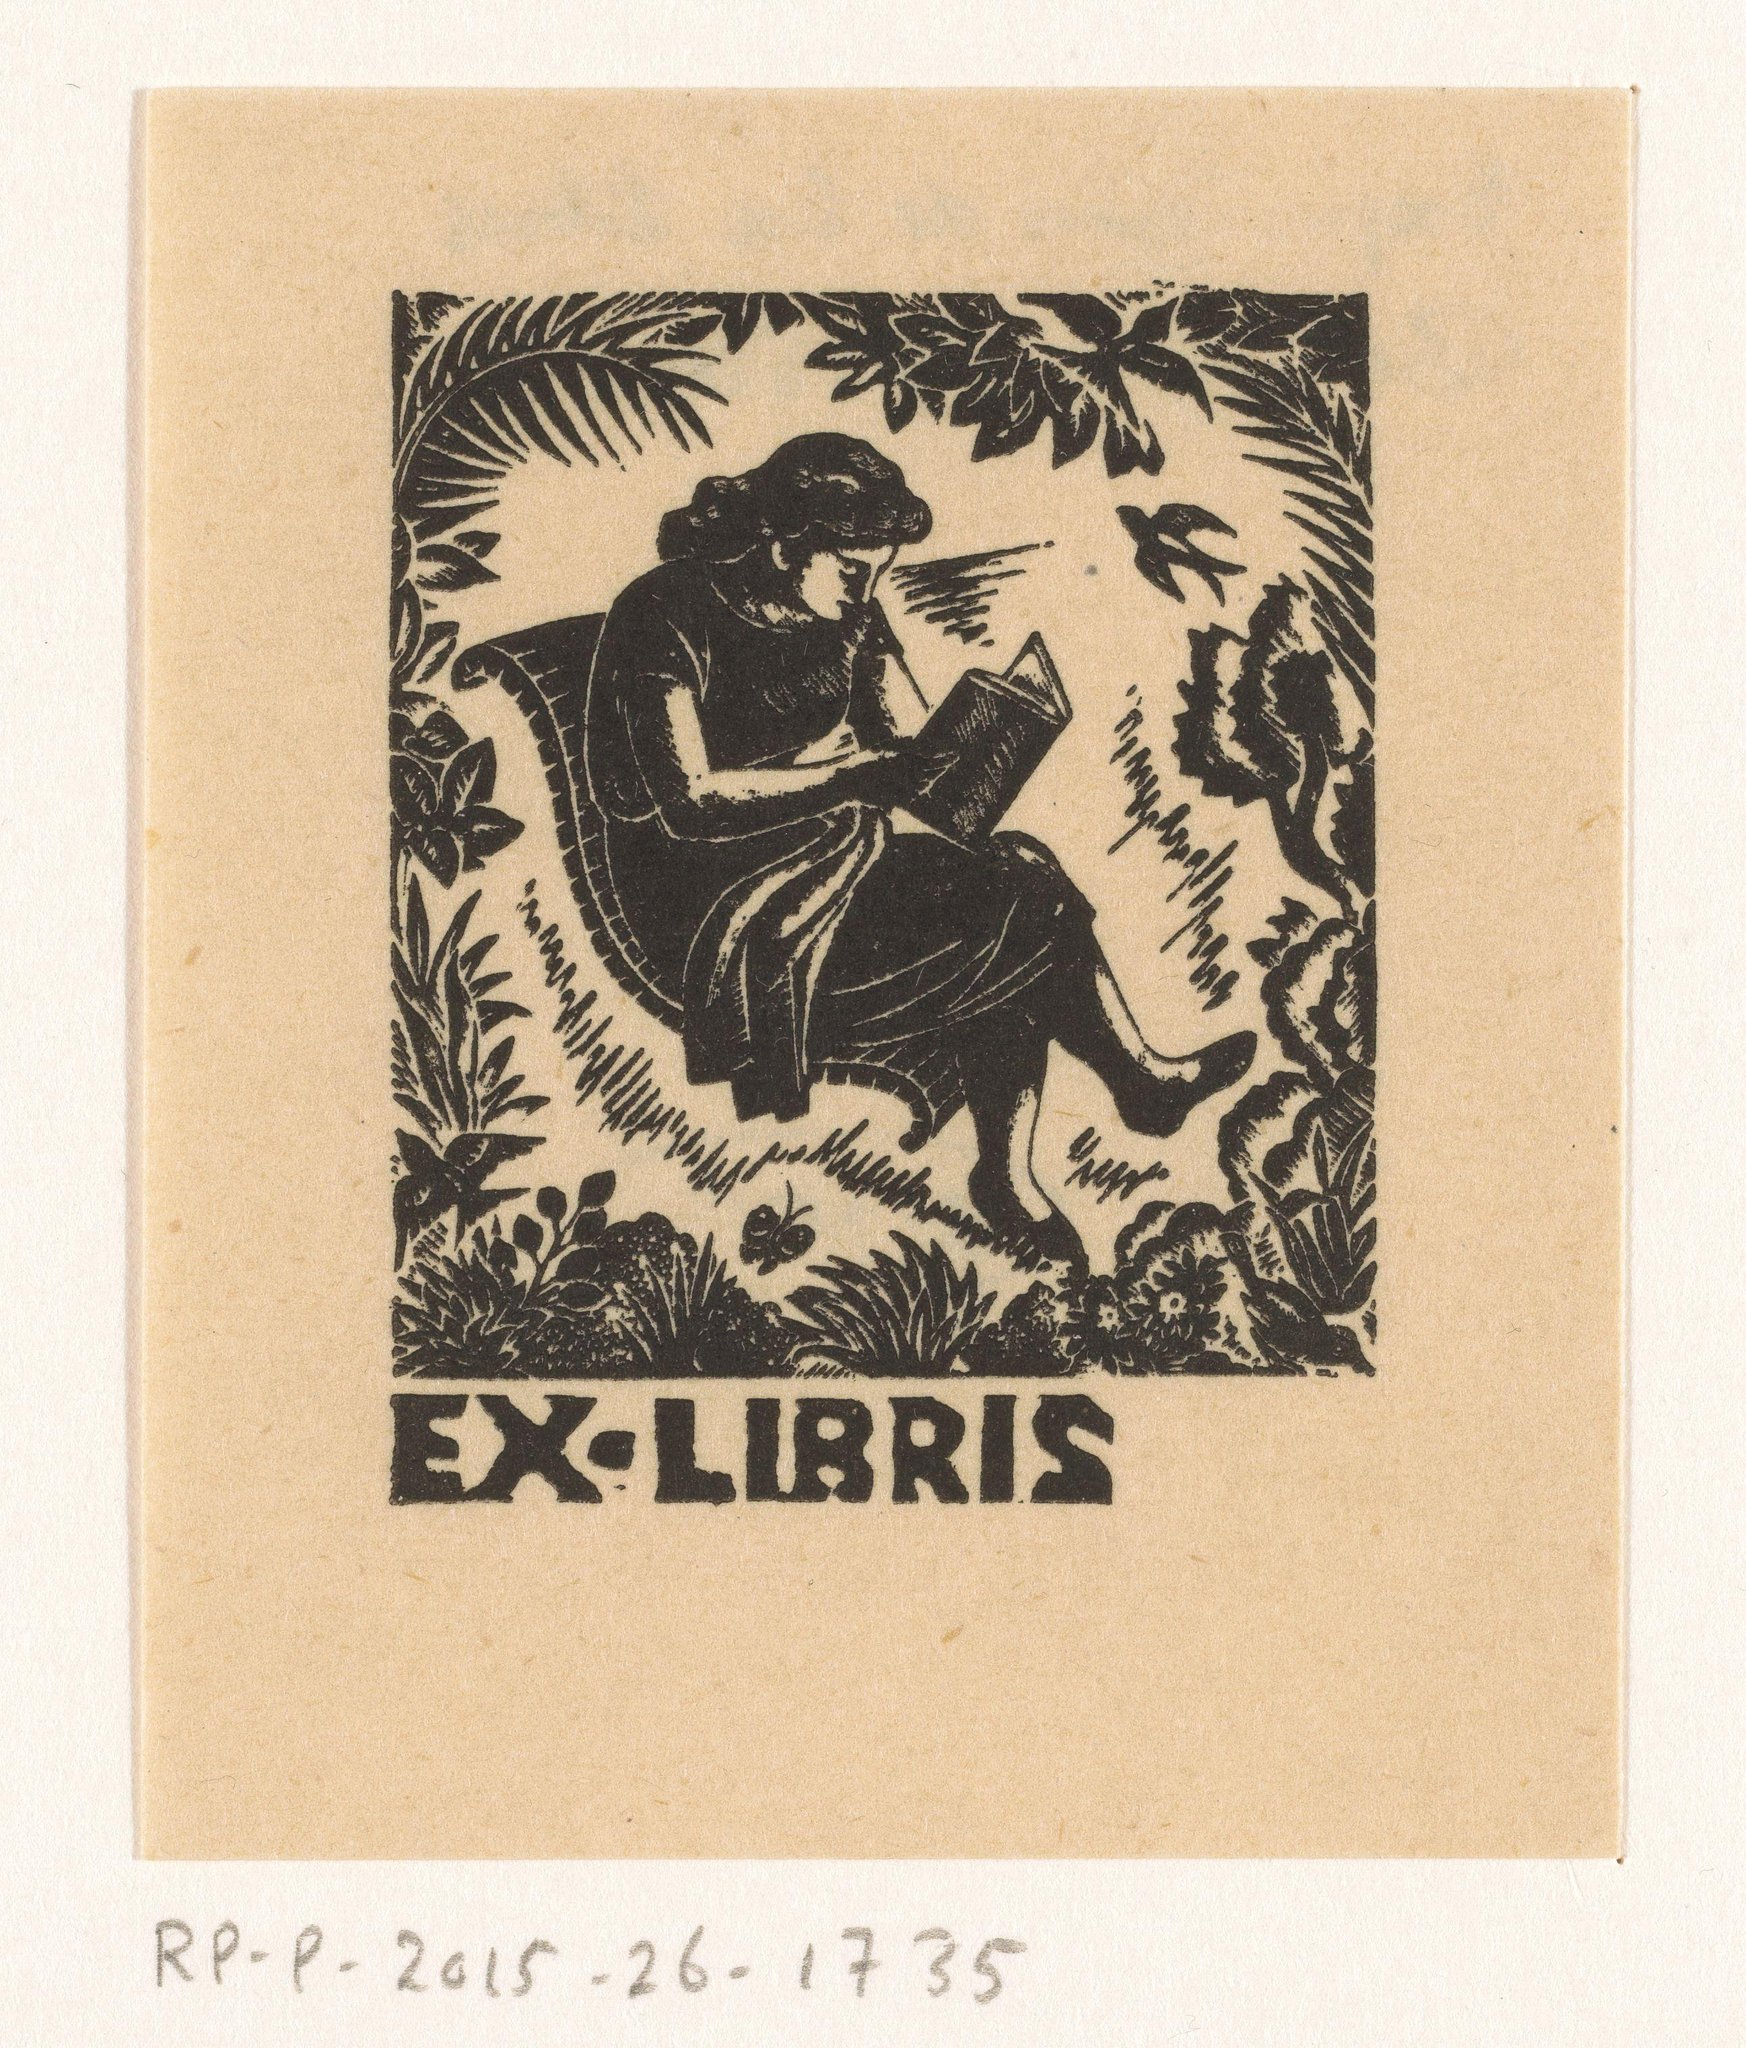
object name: print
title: Lezende vrouw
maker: Anonymous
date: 1950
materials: paper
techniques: engraving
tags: plants; vegetation, reading, book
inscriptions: collector's mark: Lugt 2228, annotation: ‘Exposicion de ex libris / Barcelona 1950’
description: Op een tuinbank zit een lezende vrouw. Om haar heen planten en een vogel.